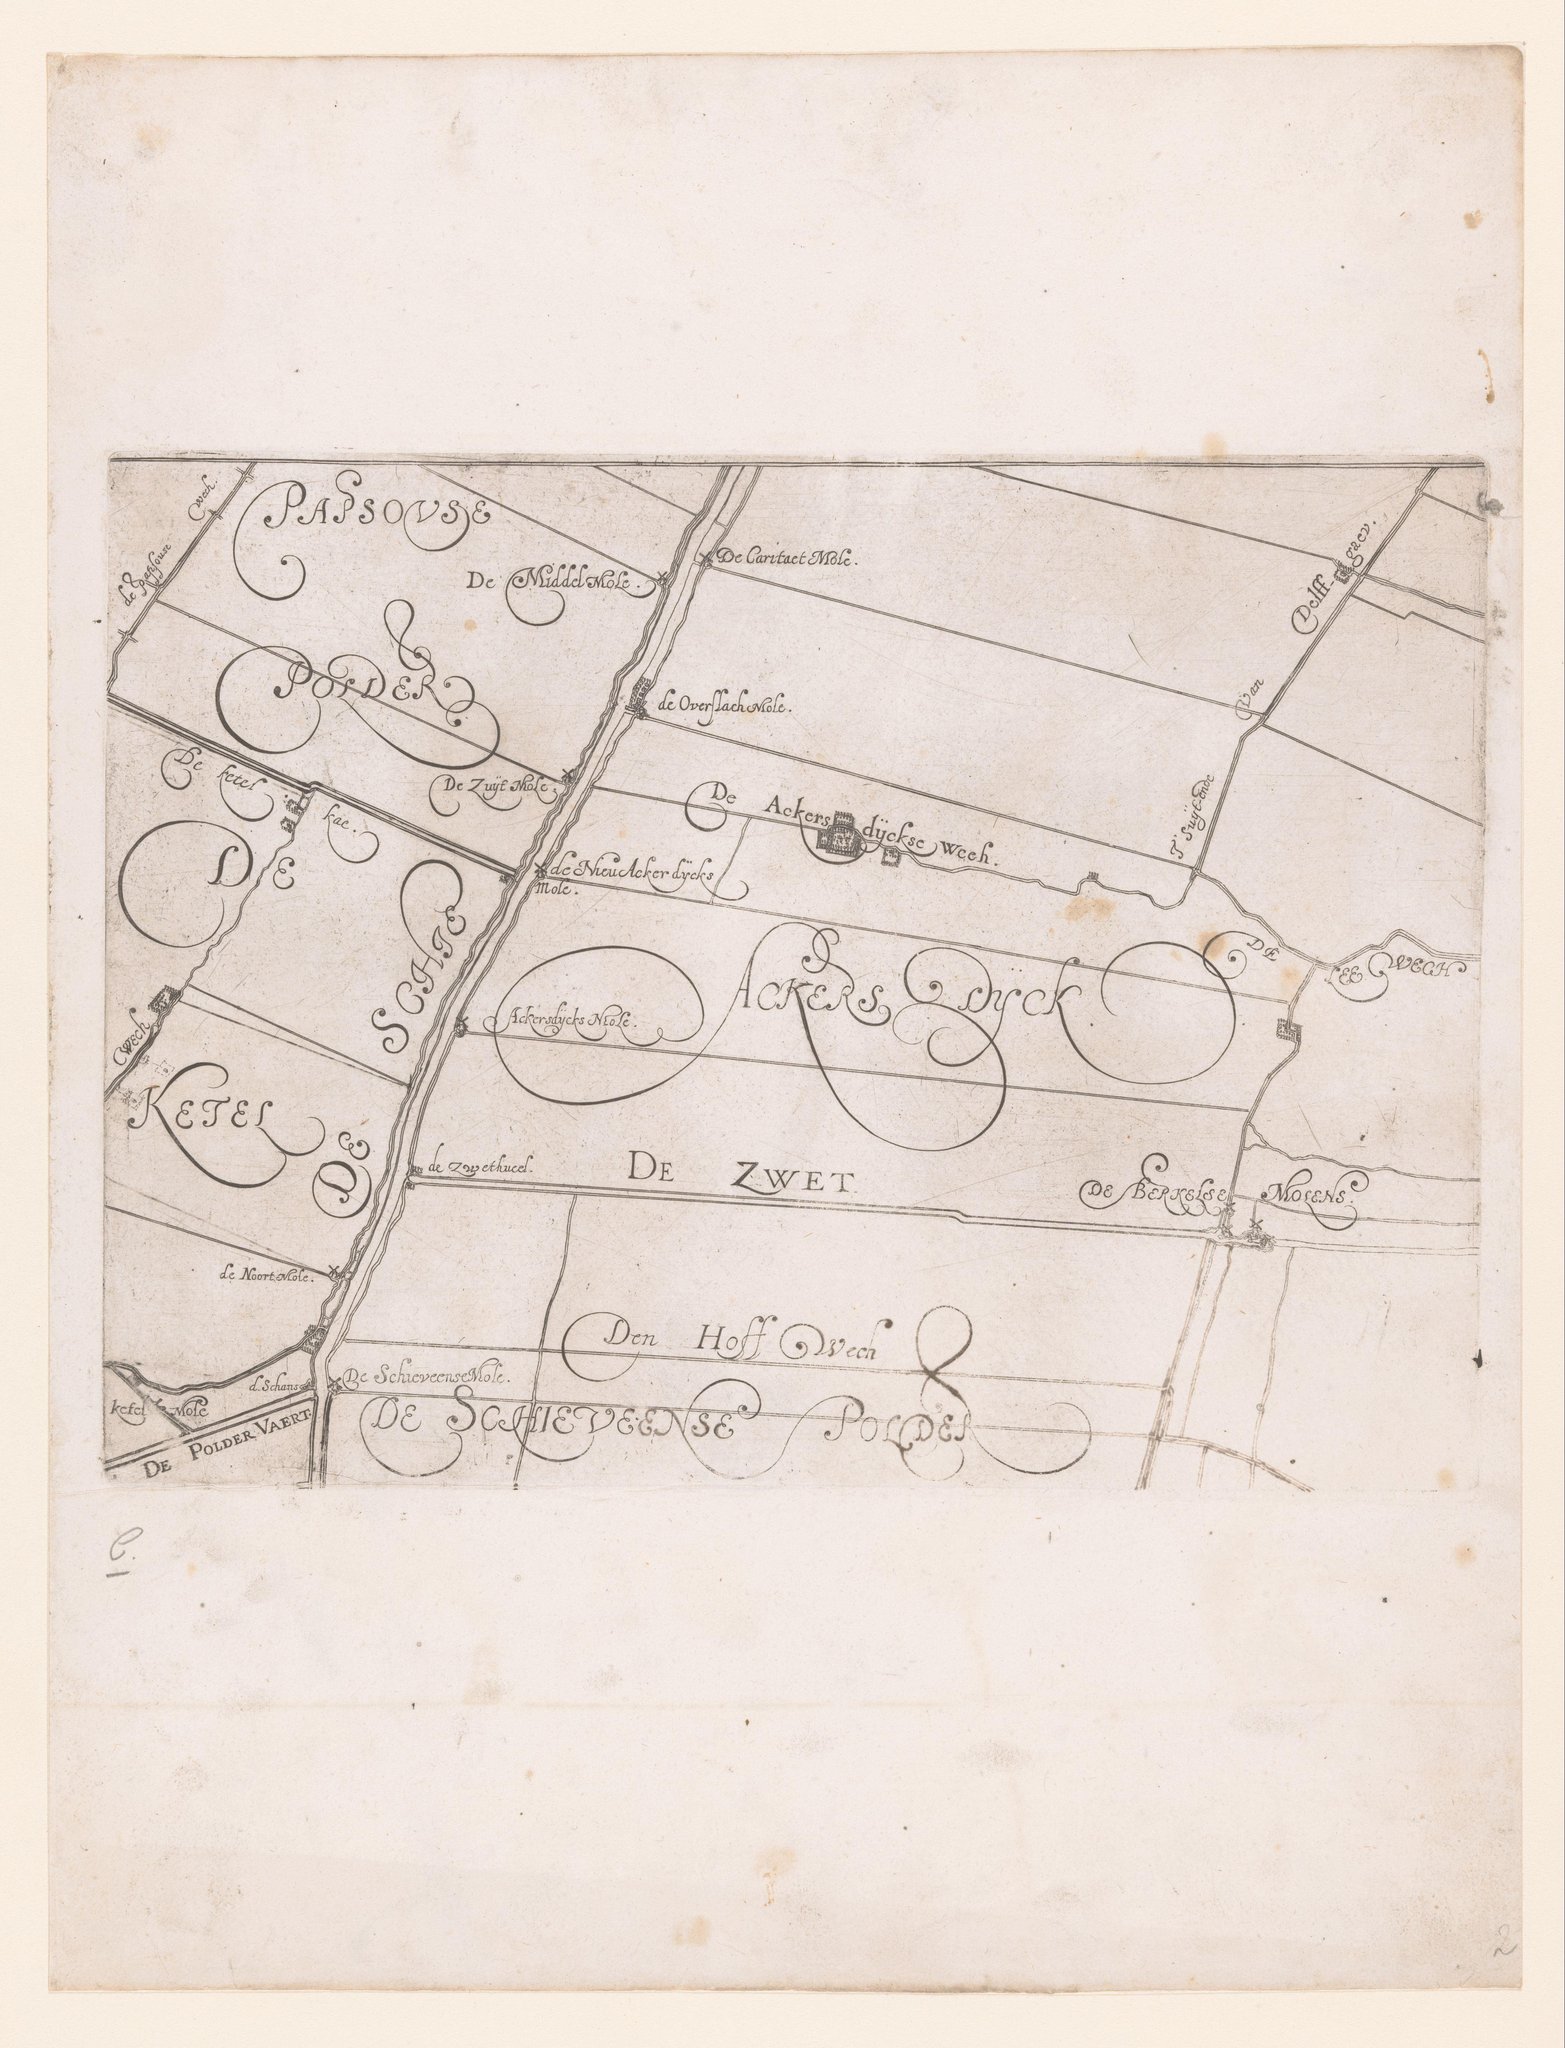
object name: map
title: Kaart van het Hoogheemraadschap van Schieland, met De Zweth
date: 1611-1635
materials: paper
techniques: engraving, etching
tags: maps of separate countries or regions, armorial bearing, heraldry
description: Deze kaart is tussen 1611 en 1635 vijf keer uitgegeven zonder dat de platen zijn bijgewerkt. Onduidelijk tot welke uitgave dit exemplaar behoort.